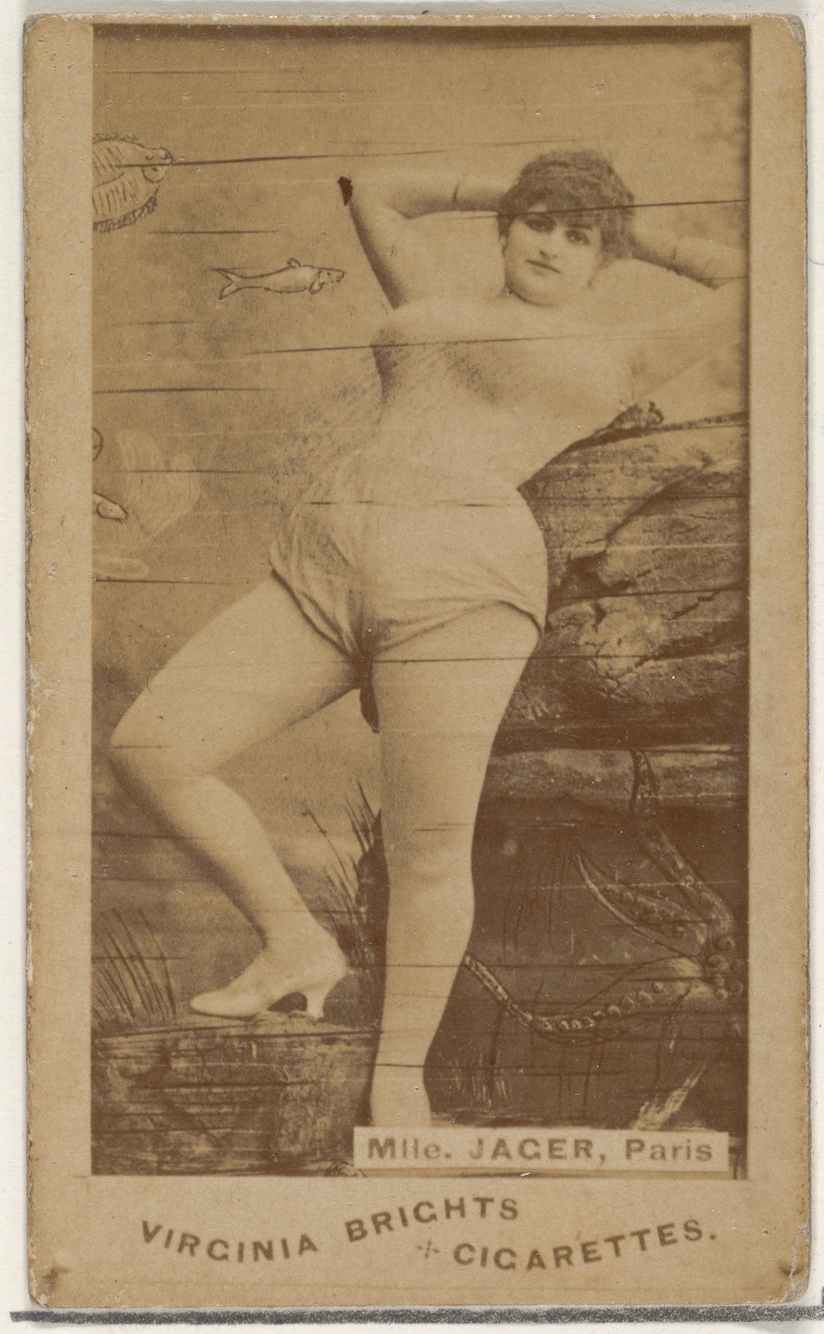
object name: photograph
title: Mlle. Jager, Paris, from the Actors and Actresses series (N45, Type 1) for Virginia Brights Cigarettes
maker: allen & ginter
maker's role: publisher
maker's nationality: american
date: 1888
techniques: albumen silver print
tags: portraits,women,actresses